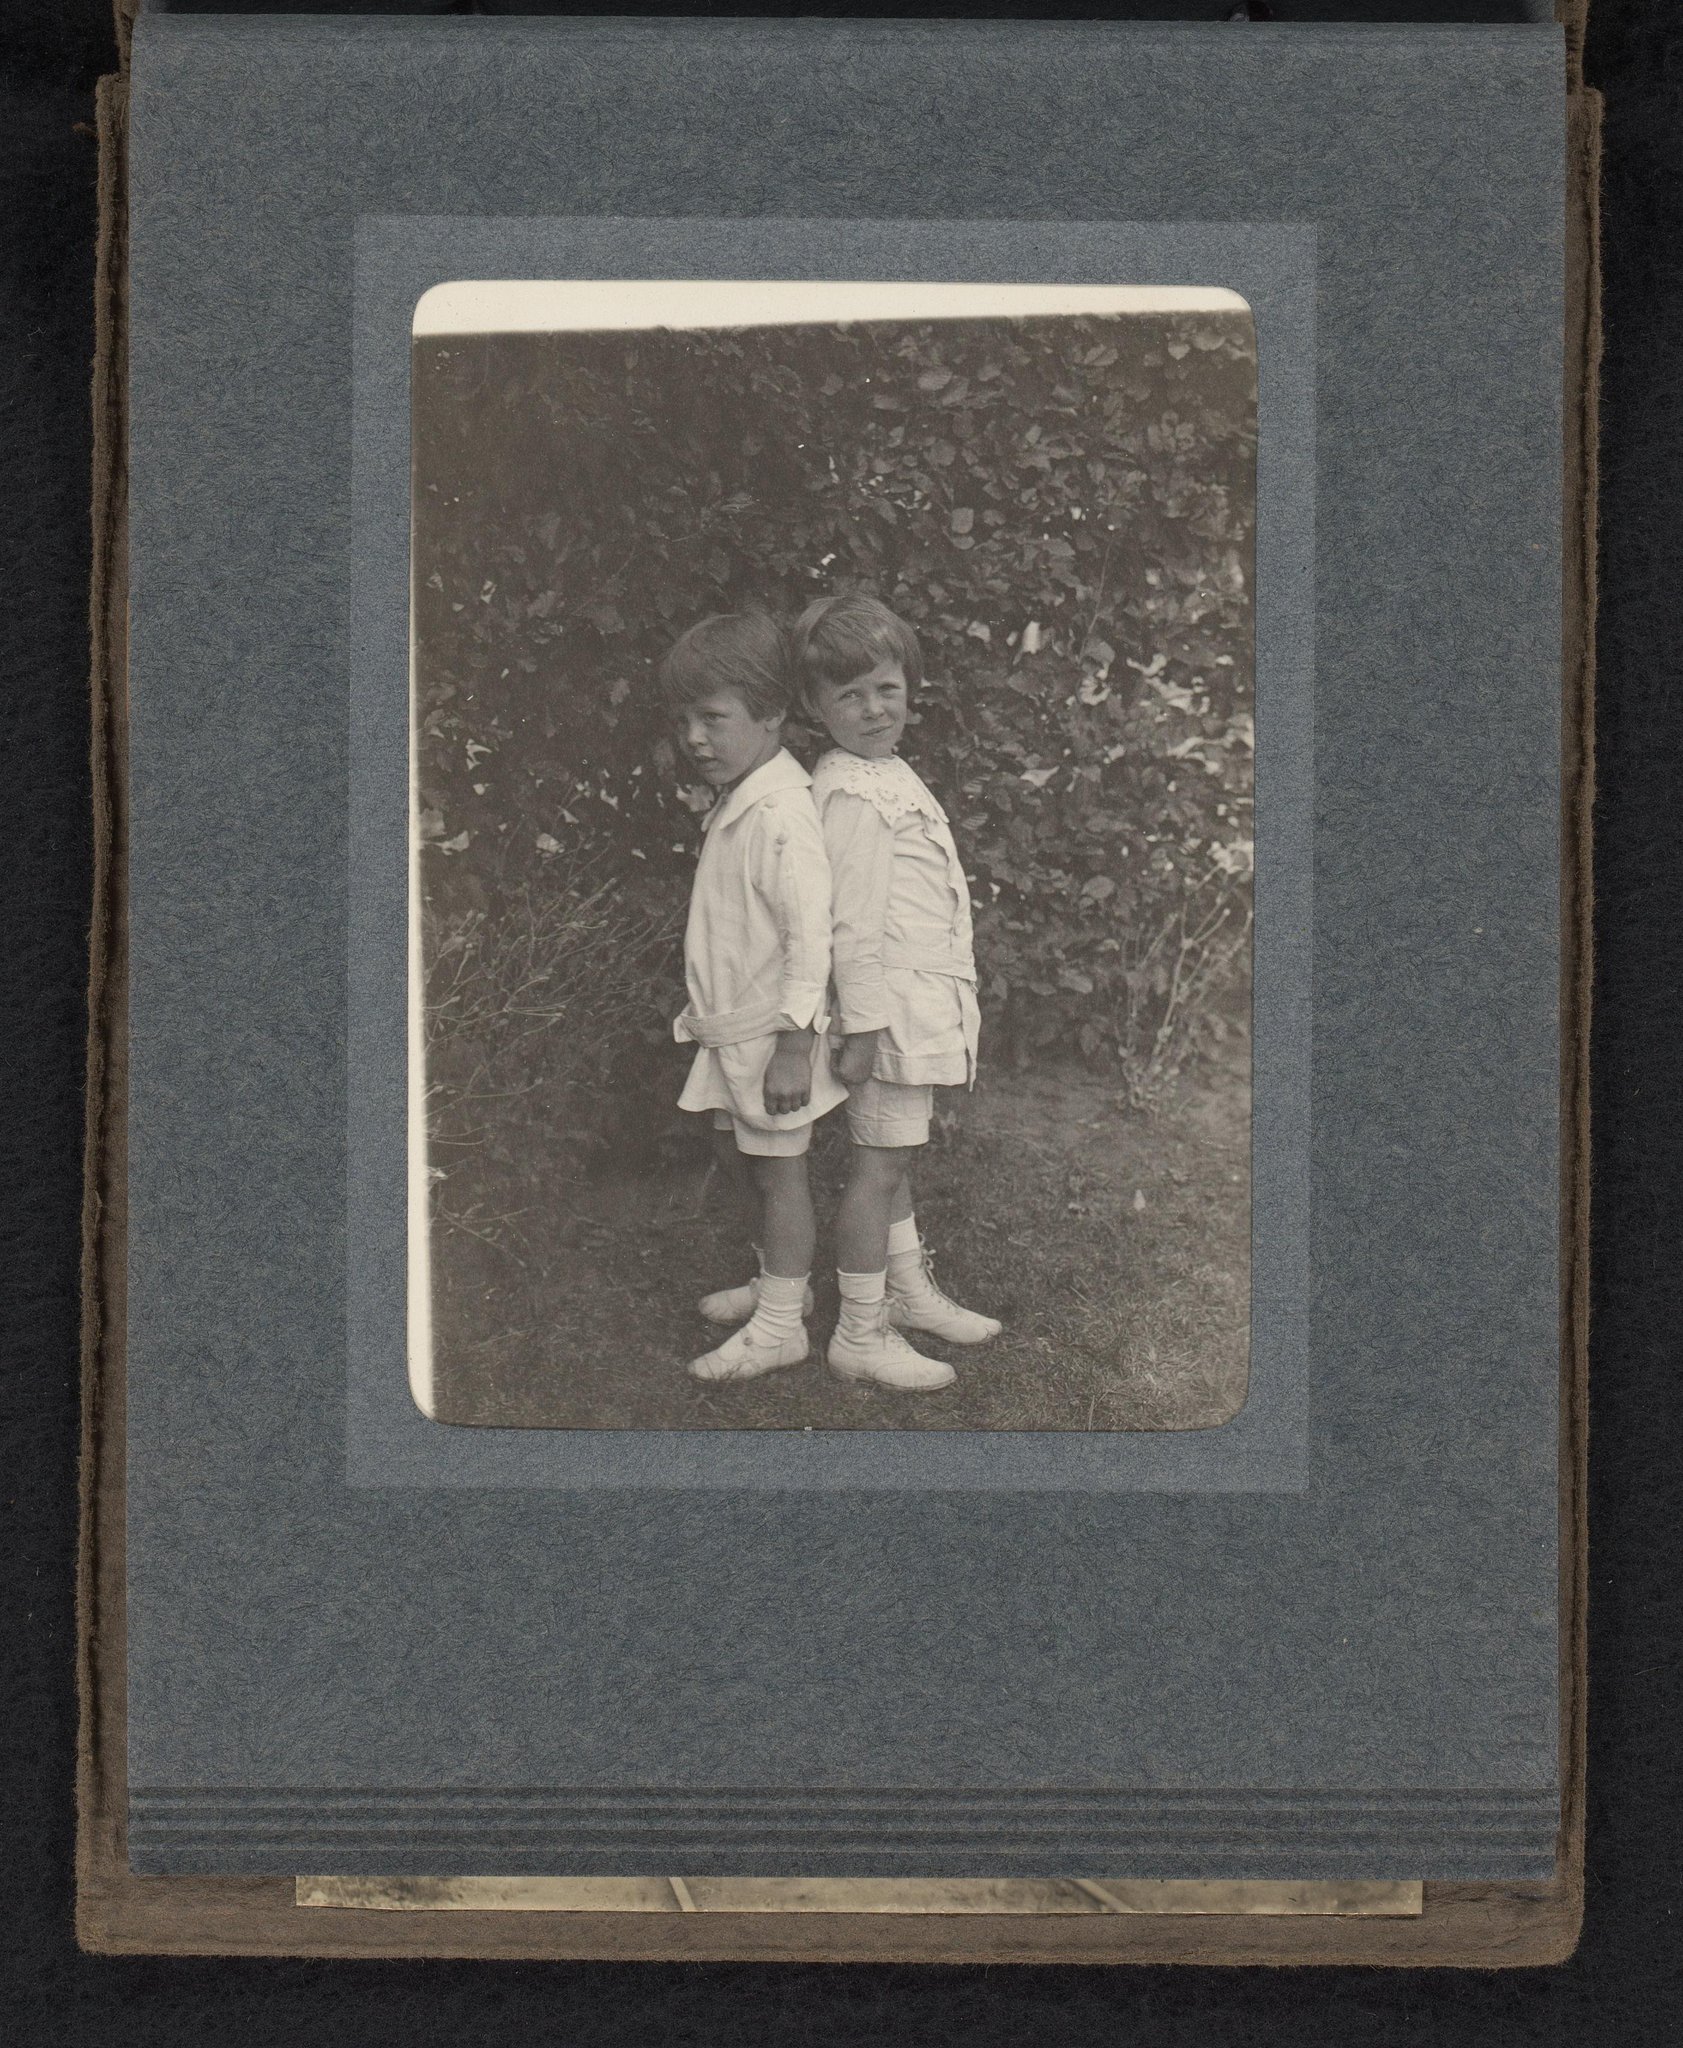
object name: album leaf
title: Portret van Cay van den Berg en een andere jongen in de tuin te Blaricum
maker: hendrik herman van den berg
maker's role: amateurfotograaf, jurist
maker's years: 1875-1944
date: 1913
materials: paper, cardboard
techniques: gelatin silver print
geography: blaricum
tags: carel frederik van den berg (cay), child, historical persons, garden pond